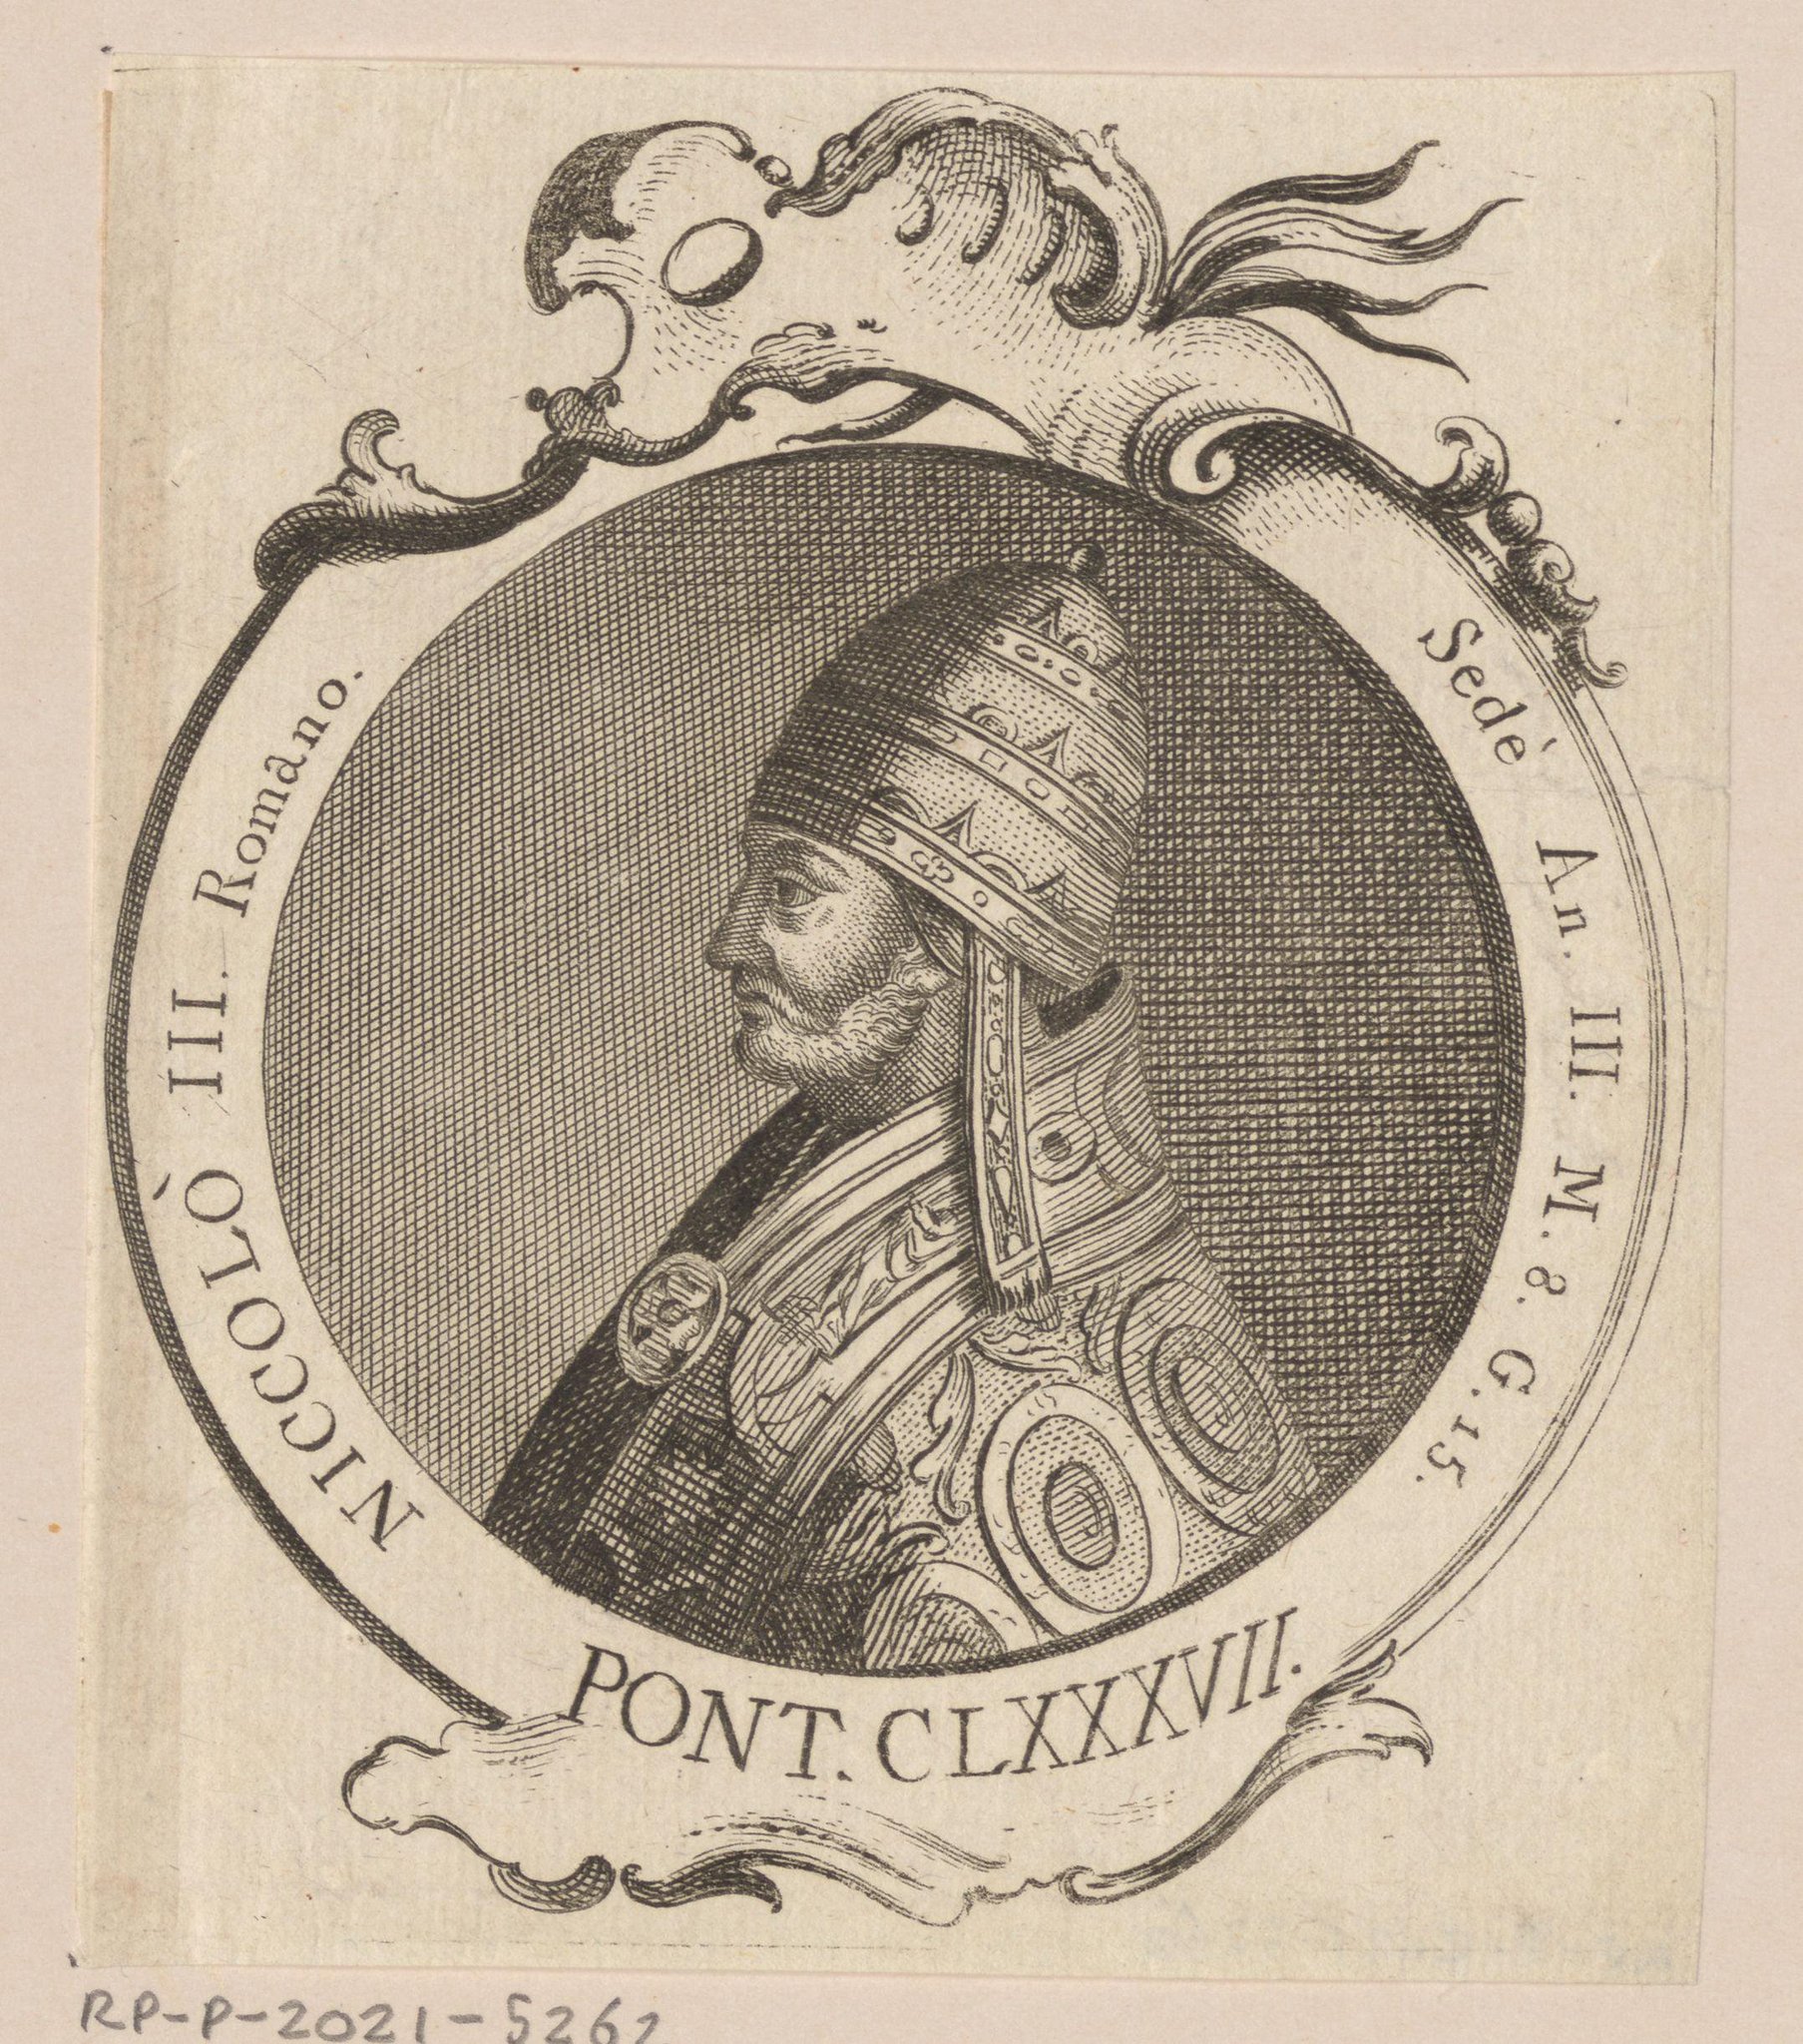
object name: print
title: Portret van paus Nicolaas III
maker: Anonymous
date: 1760-1775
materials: paper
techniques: etching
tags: rome, historical persons, pope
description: Prent waarschijnlijk uit: Effigies Romanorum pontificum a S. Petro ad Pium VI (...). 2 dln. Venetië en Bassano del Grappa: Giuseppe Remondini, 1775. Prent met tekst op verso gebruikt in: Platina (Bartholomaeus Sacchi). Storia delle vite dei pontefici da Platina e d'altri autori (...). Venetië: Domenico Ferrarin, 1760, dl. 3, p. 137.